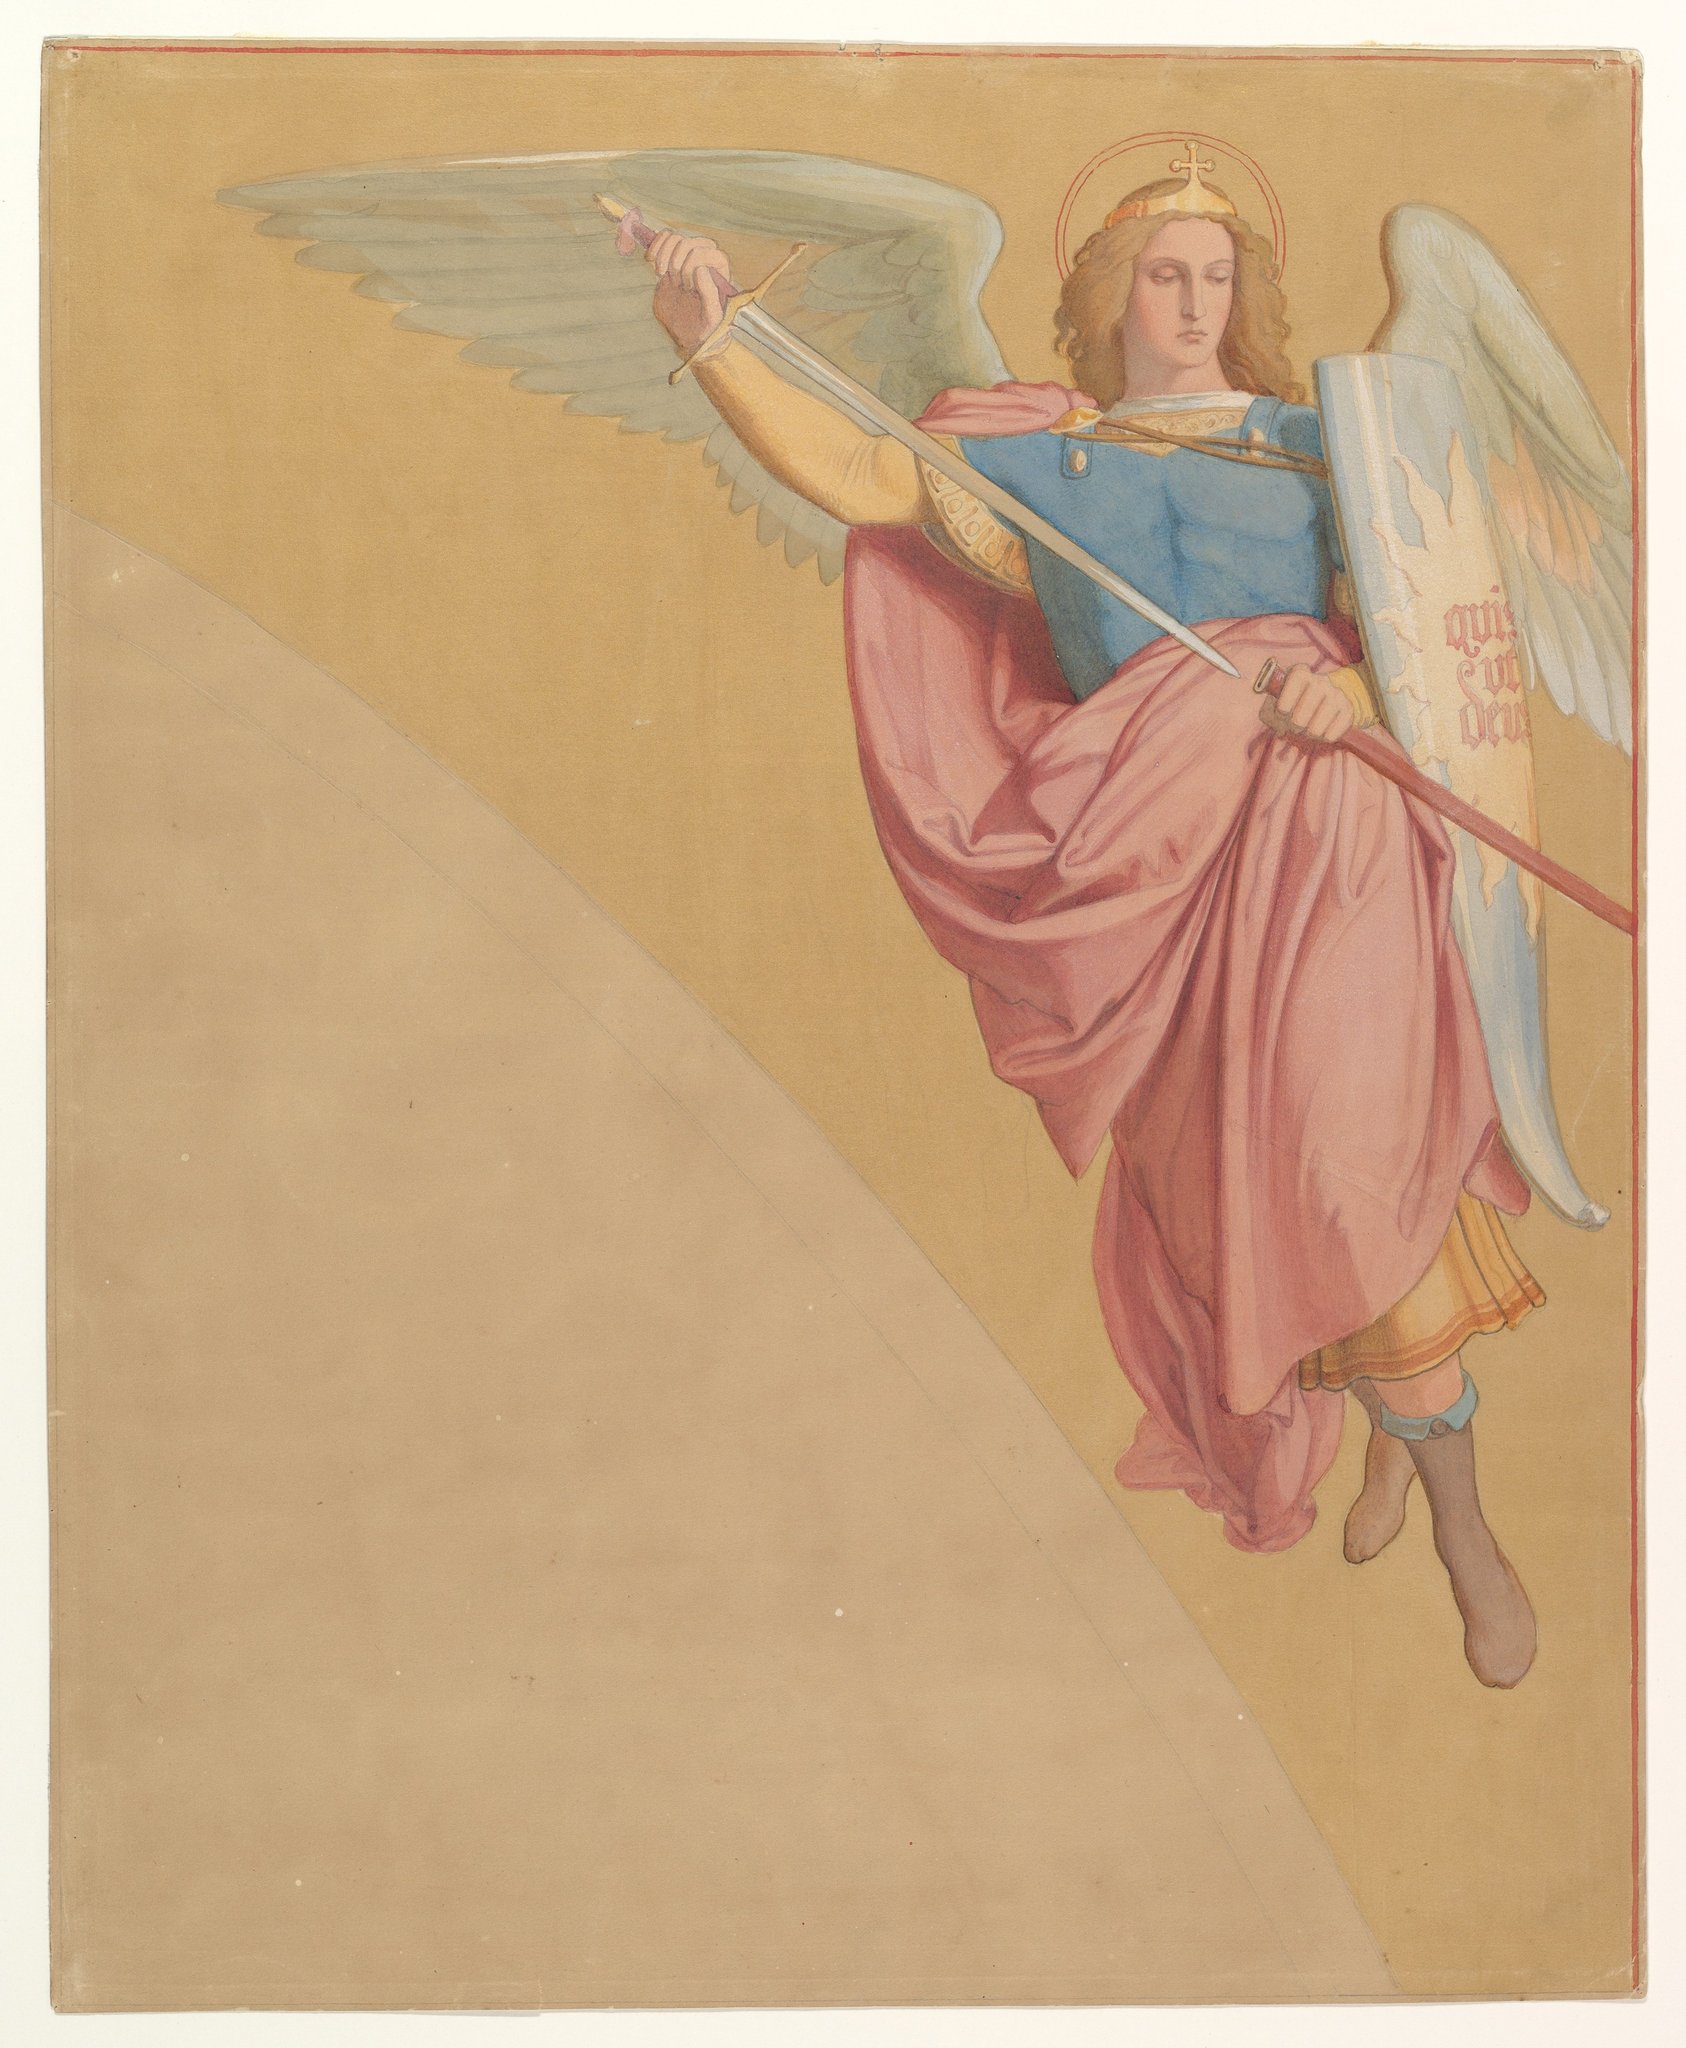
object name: drawing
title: Decoration of an Arch: Archangel with a Sword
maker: eduard jakob von steinle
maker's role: artist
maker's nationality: austrian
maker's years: 1810-1886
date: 1825-1886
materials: chalk, gold paint, paper, watercolor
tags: swords,angels